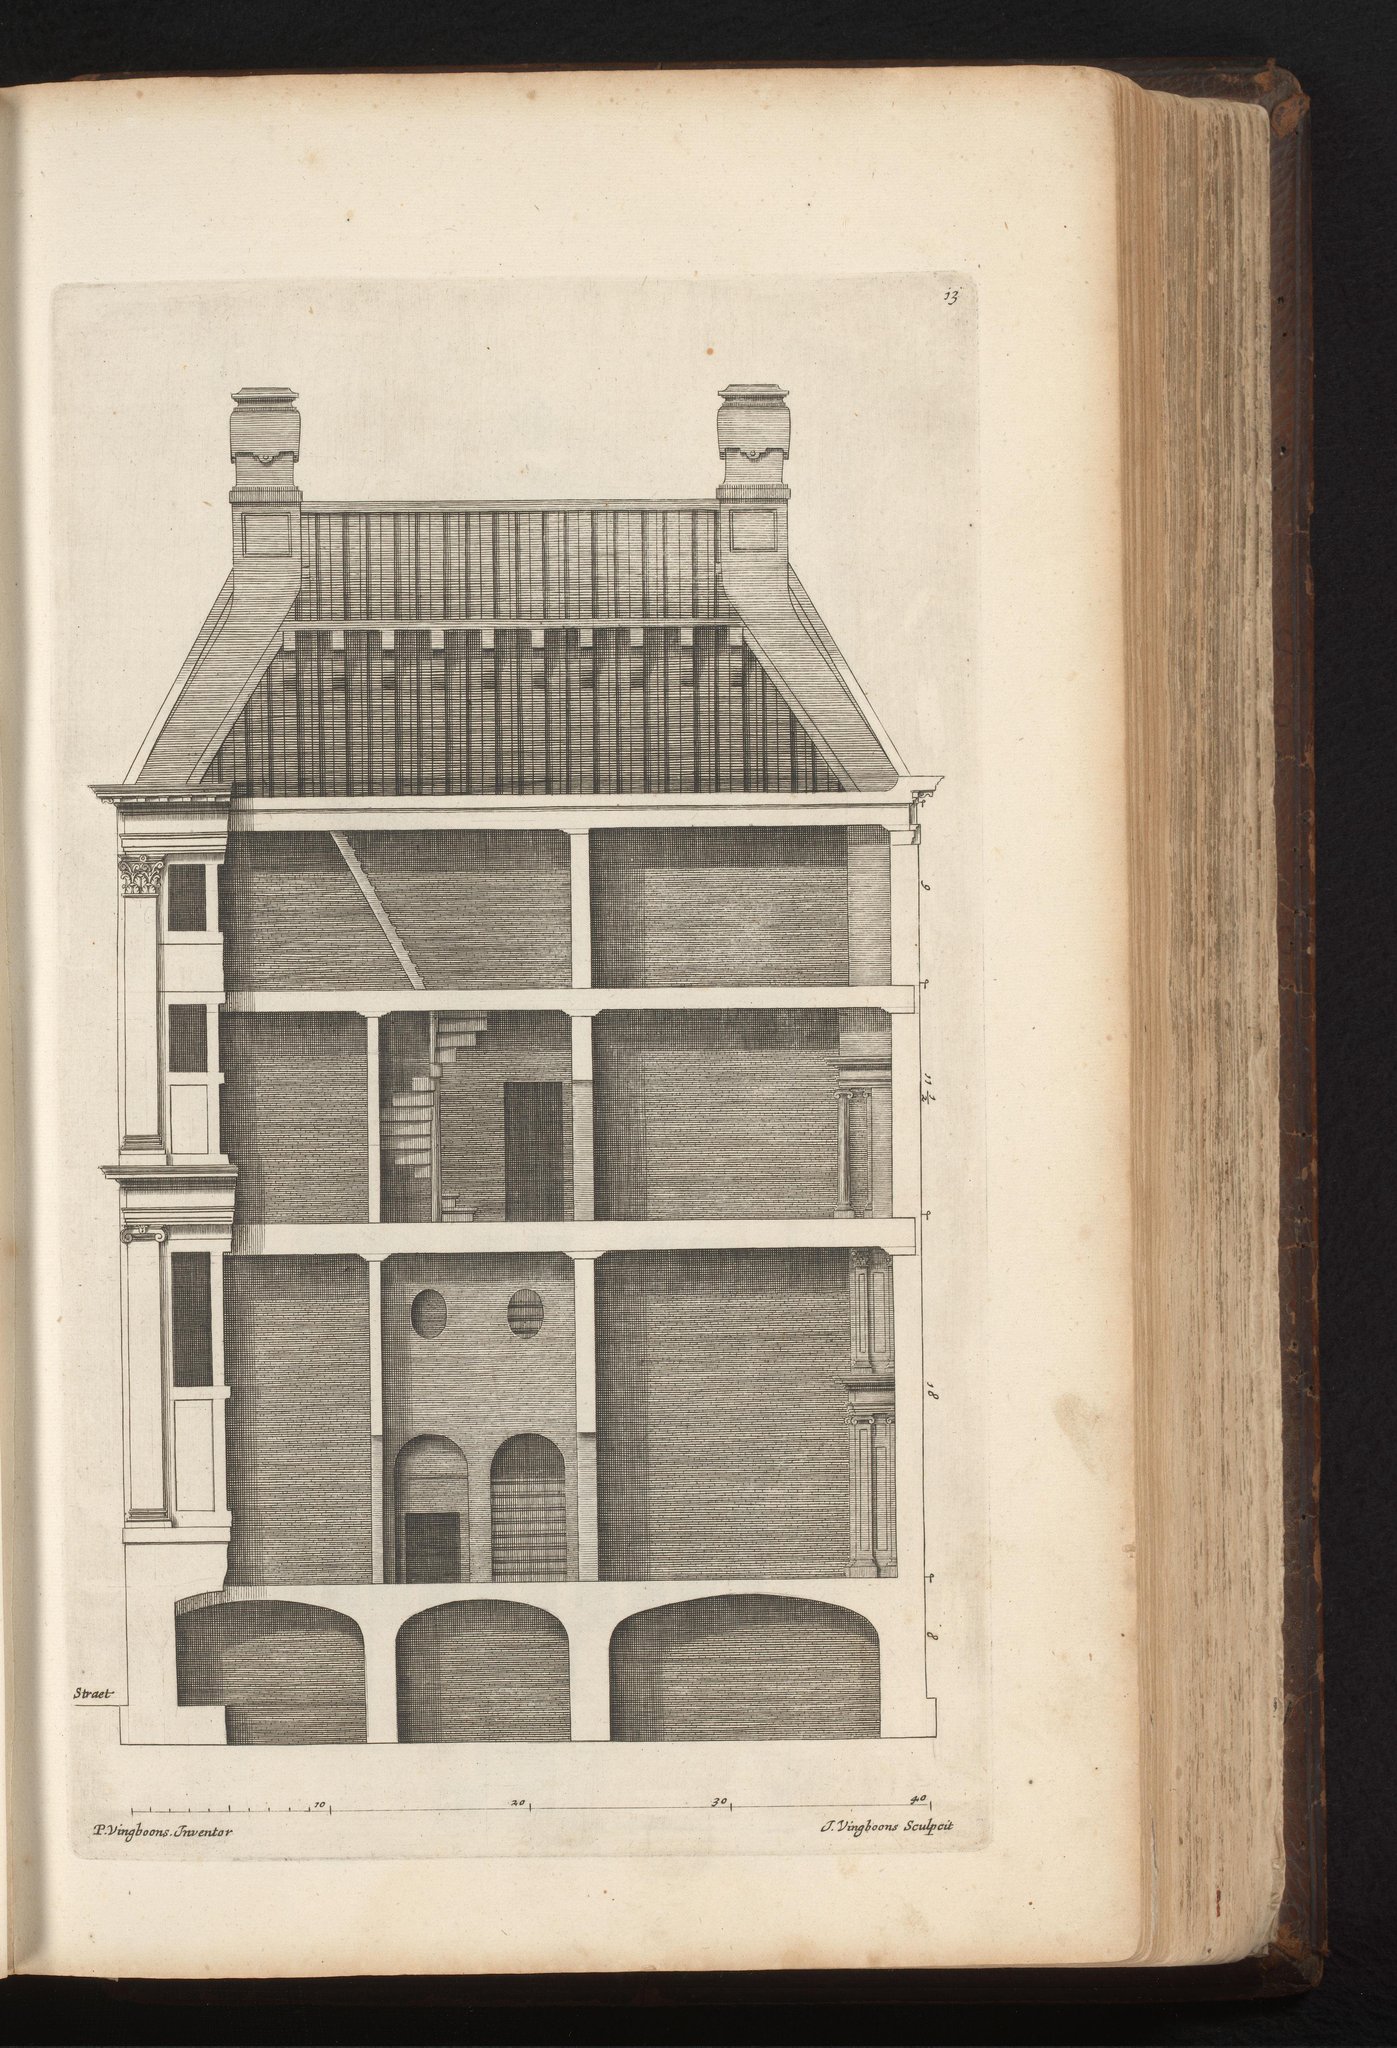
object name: print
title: Doorsnede van een huis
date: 1648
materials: paper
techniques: engraving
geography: amsterdam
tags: interior of the house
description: Prent uit: Afbeelsels der voornaemste gebouwen uyt alle die Philips Vingboons geordineert heeft. Amsterdam: Philips en Johannes Vinckboons en Johannes Willemszoon Blaeu, 1648.